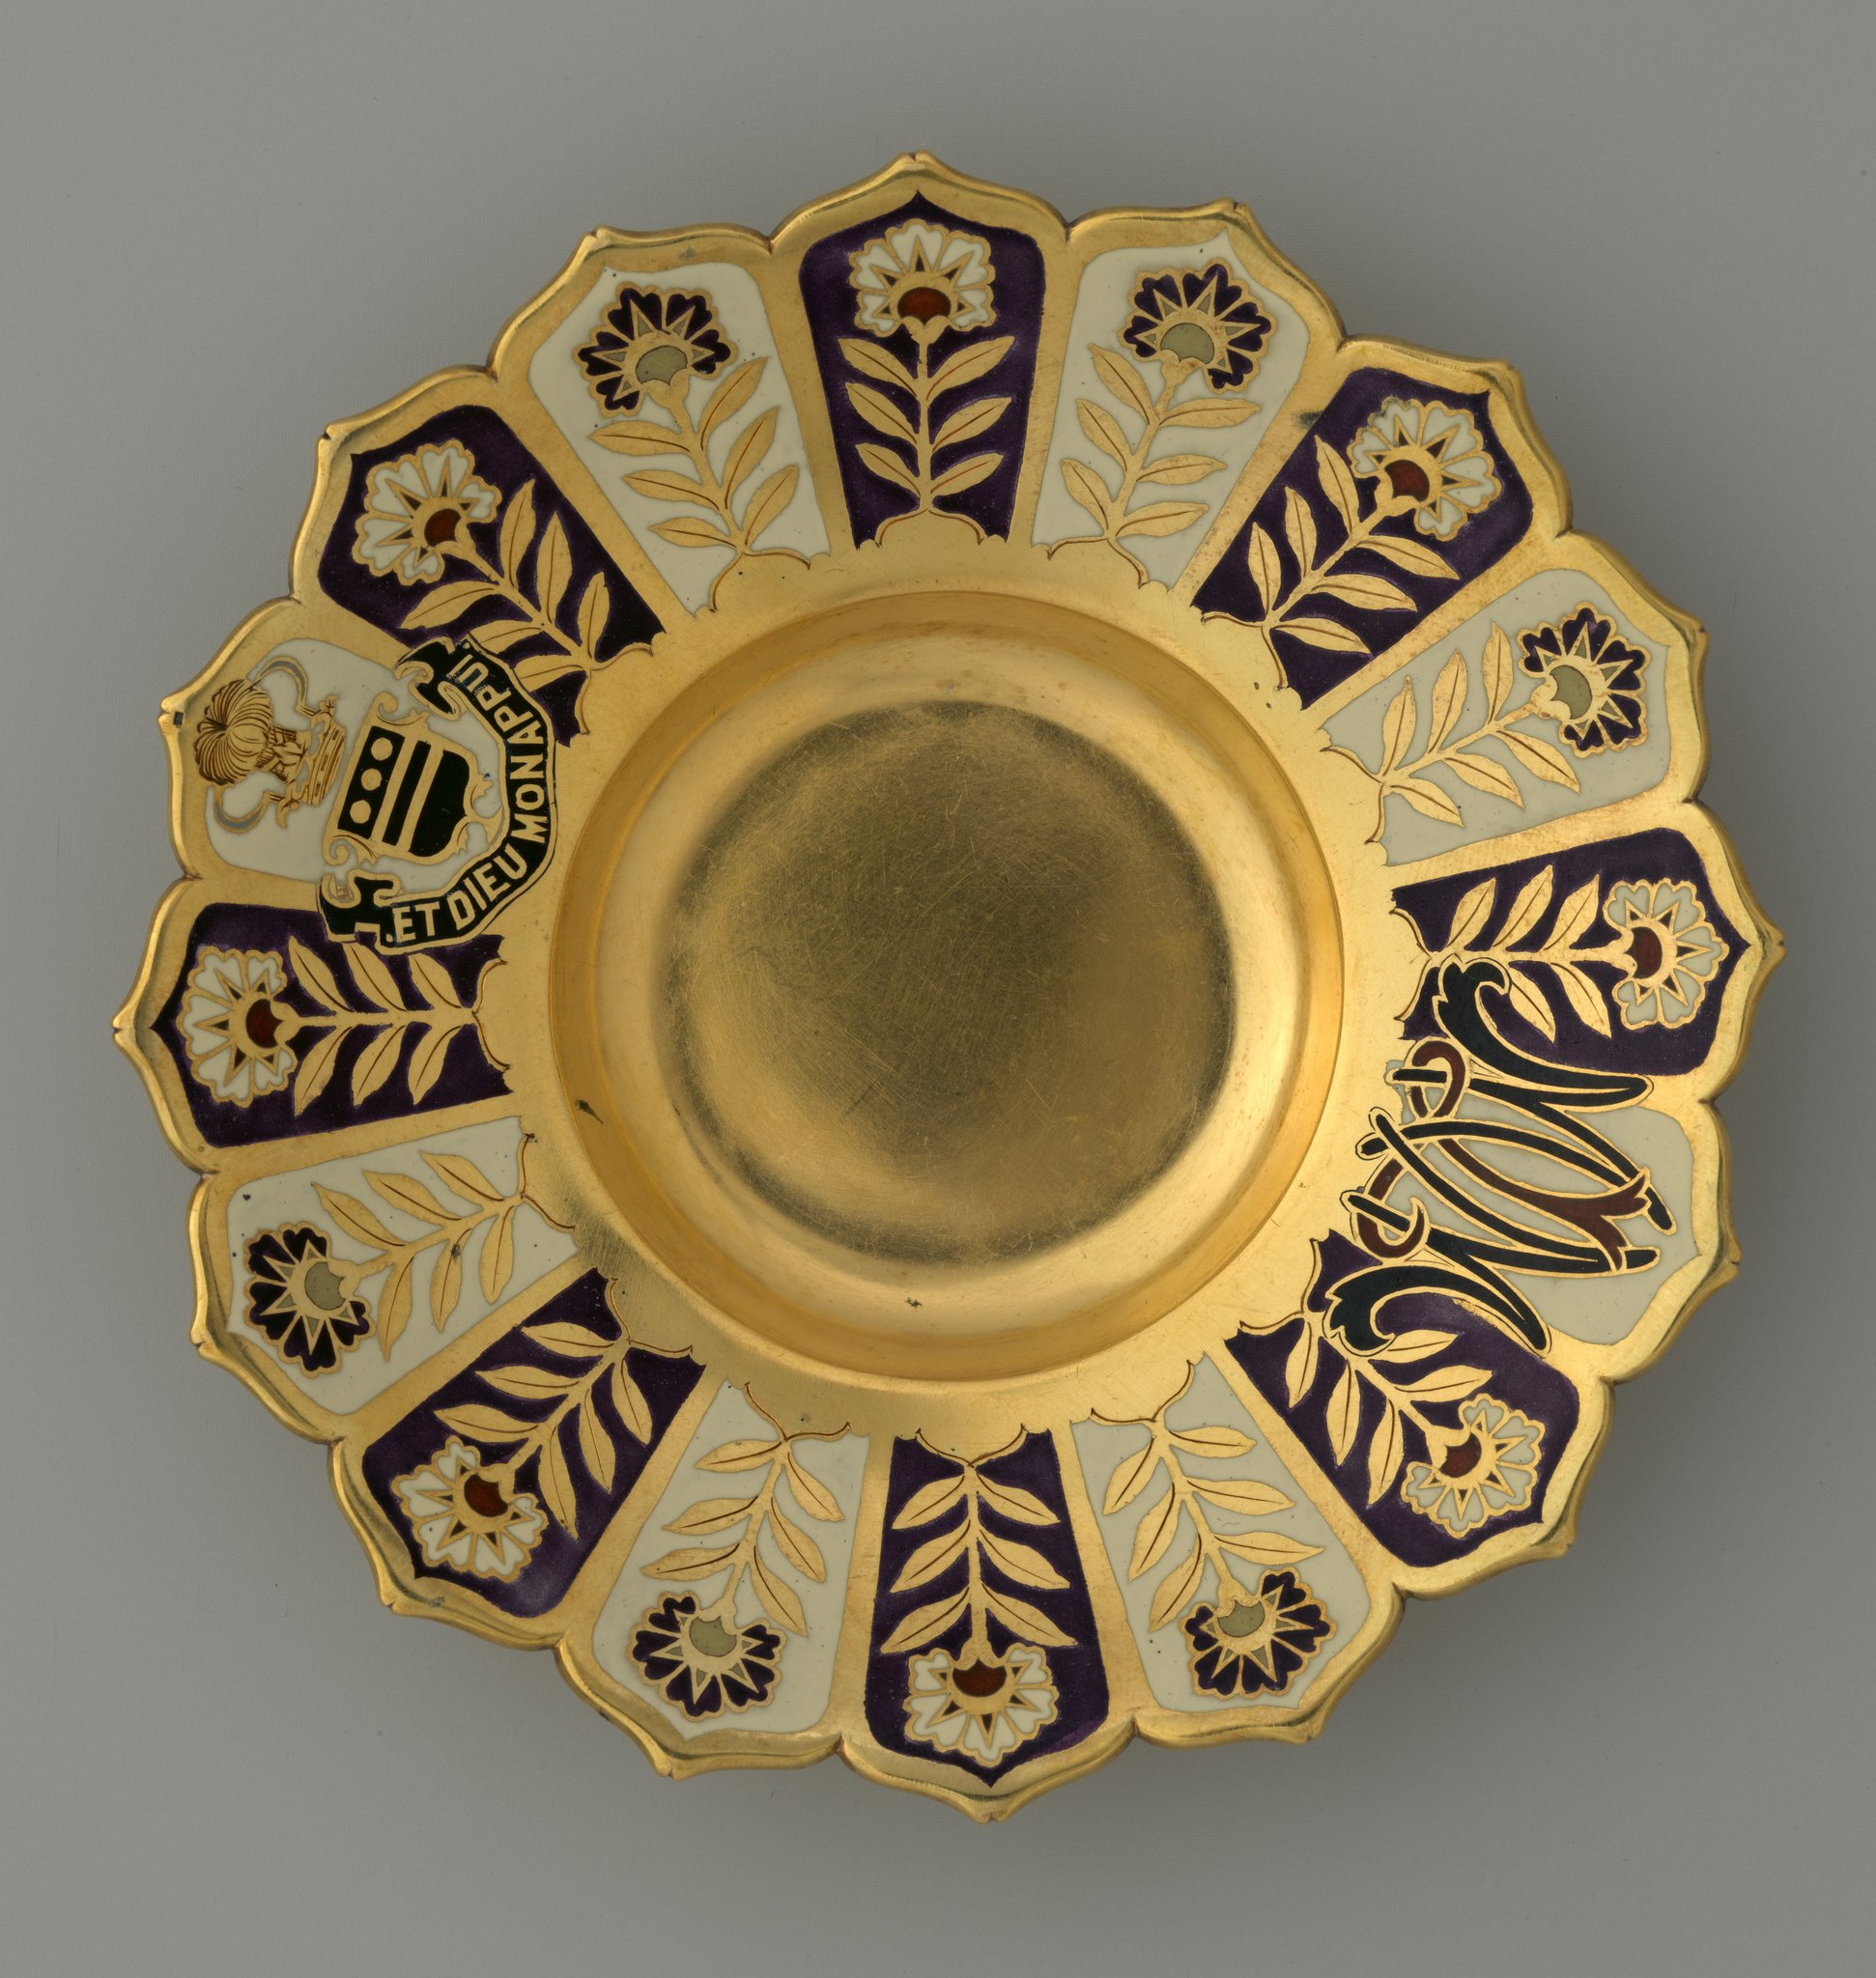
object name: saucer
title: Saucer from the Mackay Service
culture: american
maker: tiffany & co.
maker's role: maker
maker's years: 1837-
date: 1878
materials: enamel, silver gilt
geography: united states